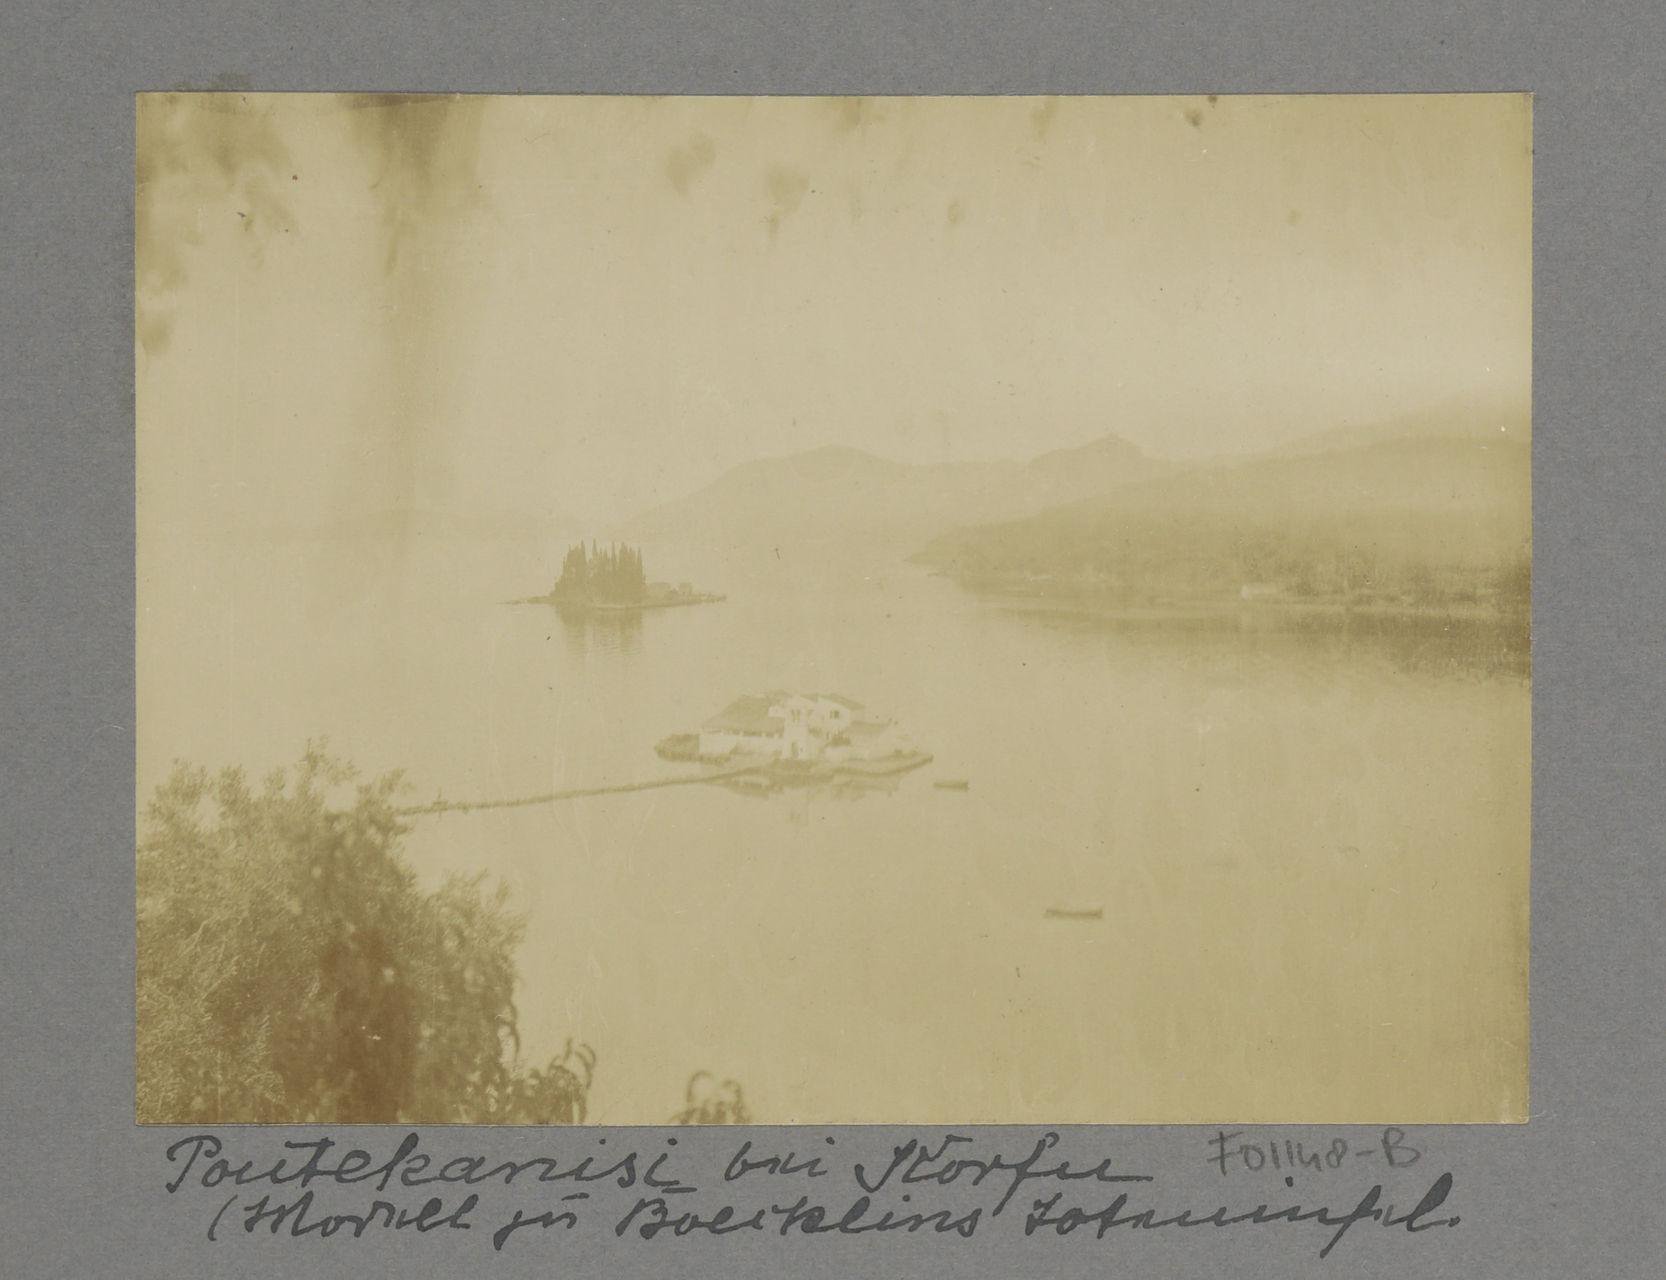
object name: photograph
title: Gezicht op Pontikonisi bij Corfu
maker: Anonymous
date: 1905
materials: paper, photographic support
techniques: gelatin silver print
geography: corfu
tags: island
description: Onderdeel van Reisalbum met foto's van bezienswaardigheden in Griekenland en Egypte.